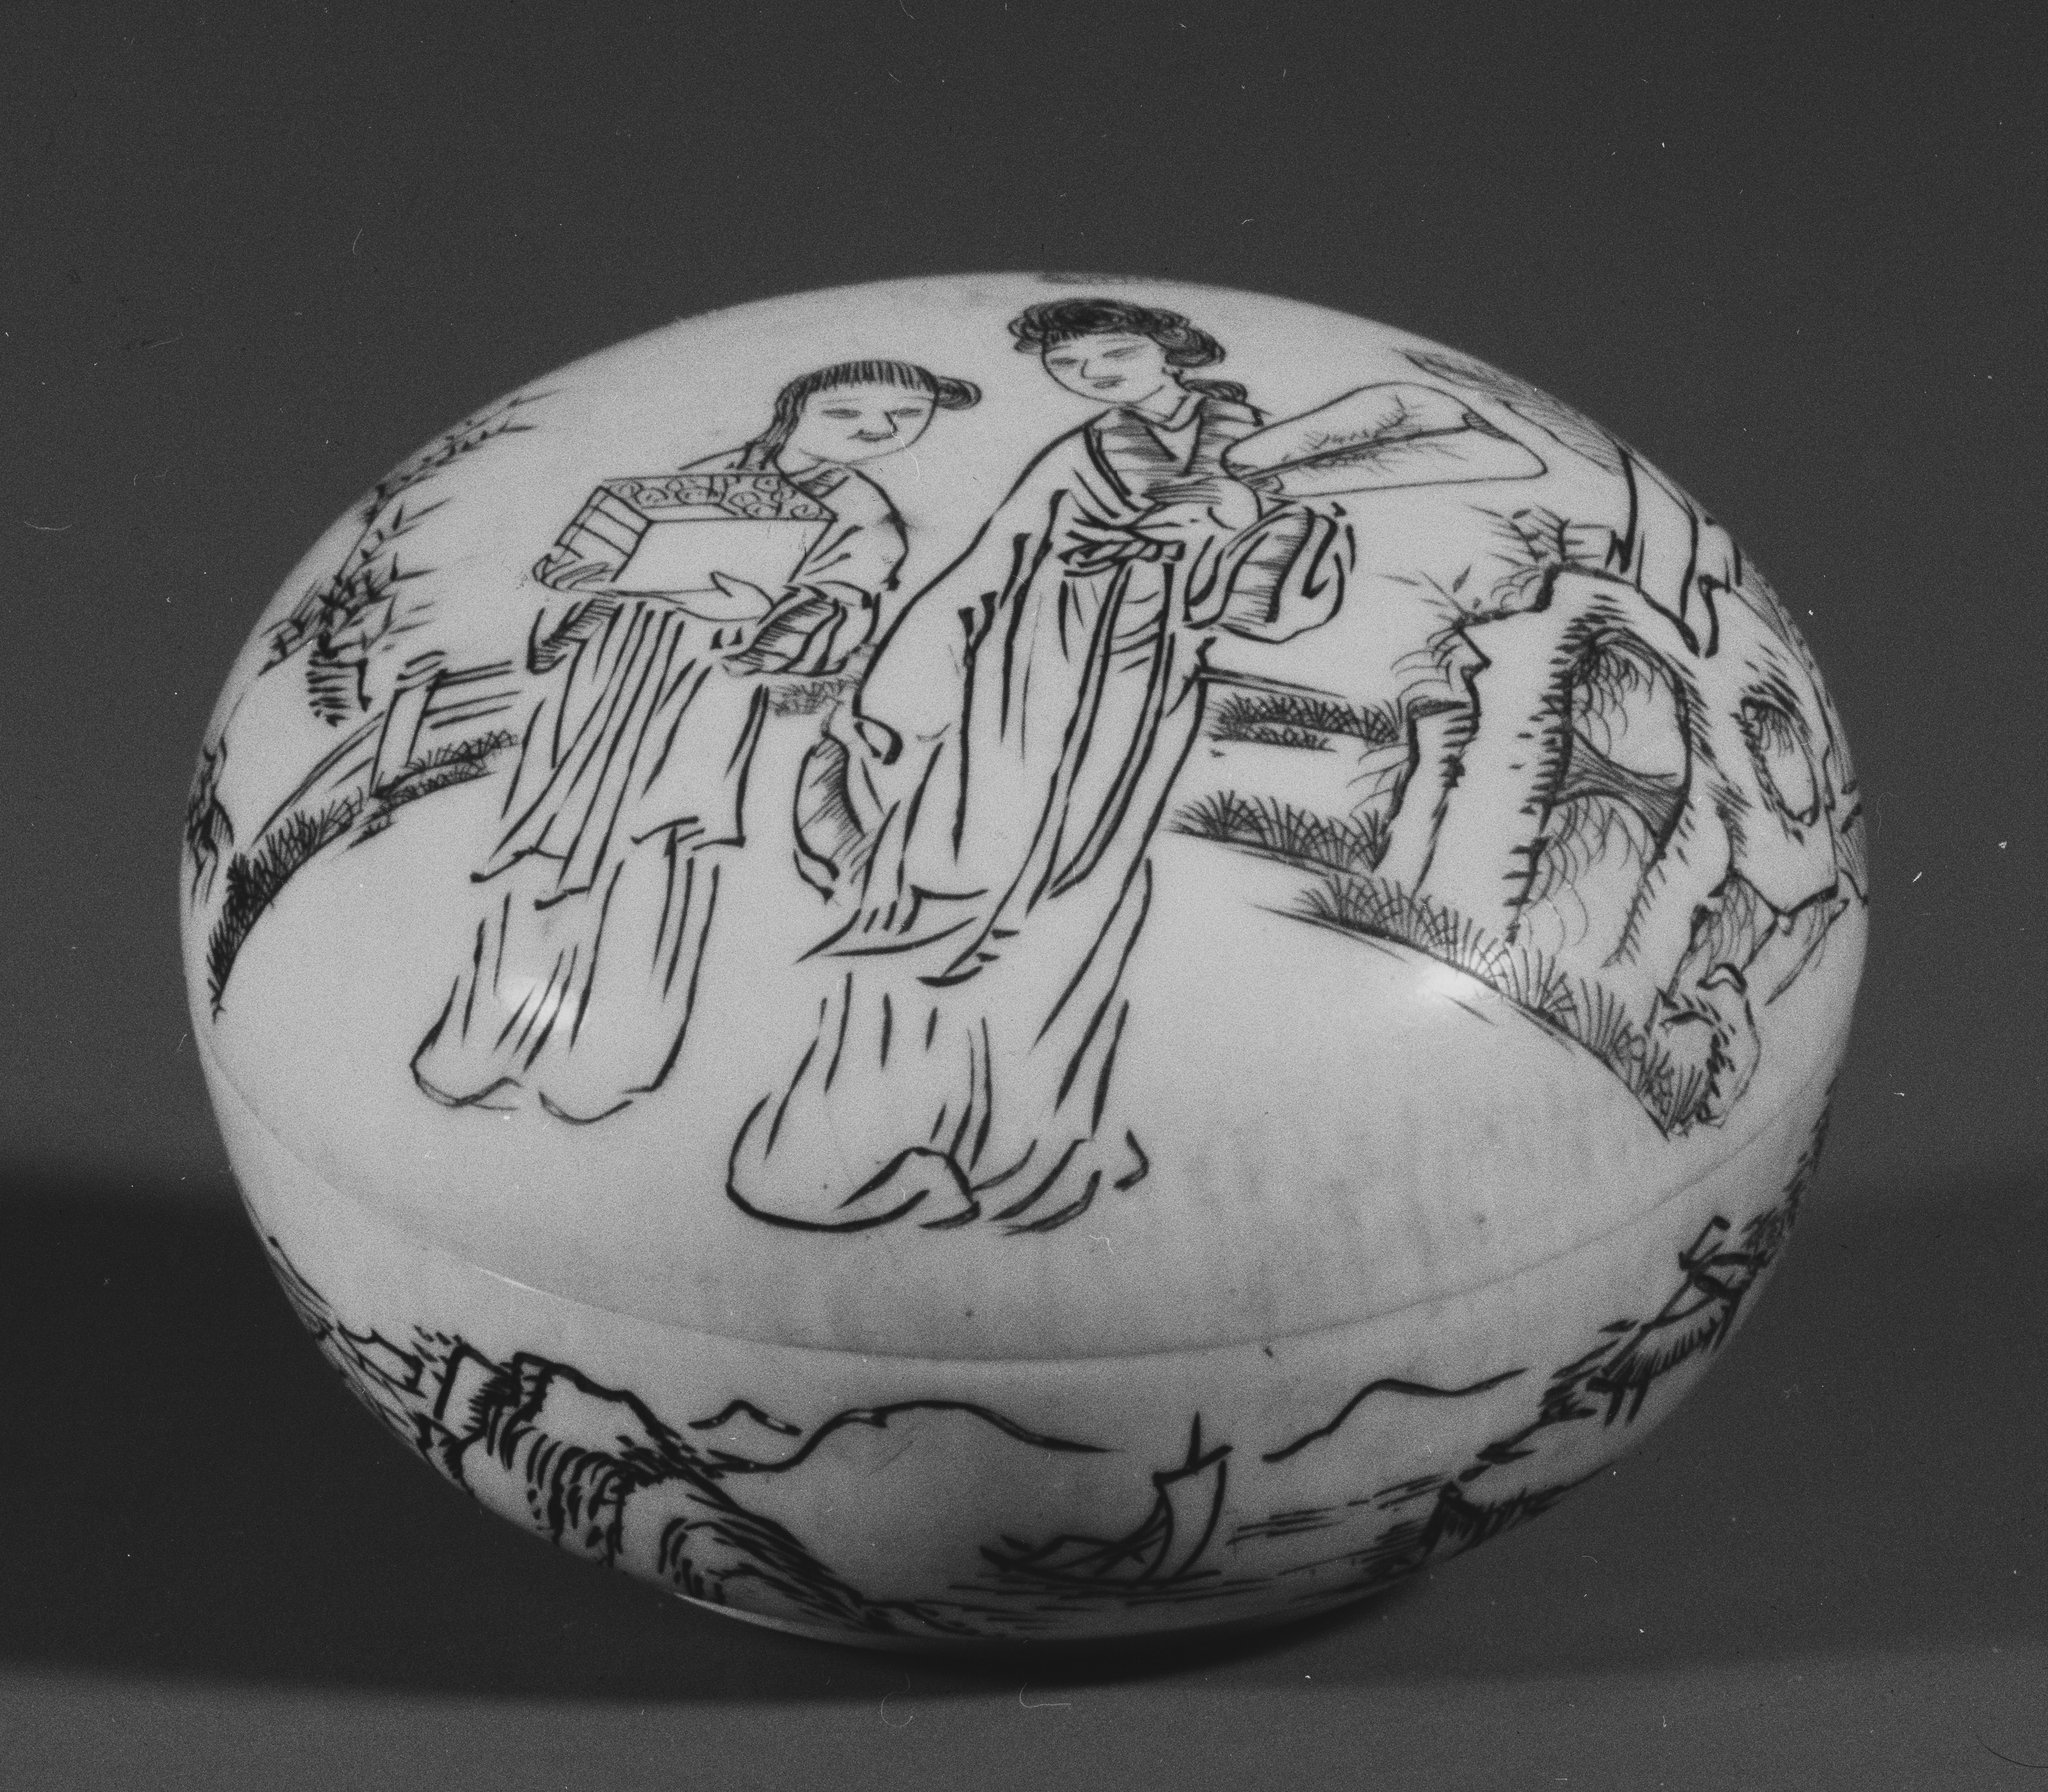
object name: pill box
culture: chinese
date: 1867-1900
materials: ivory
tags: women